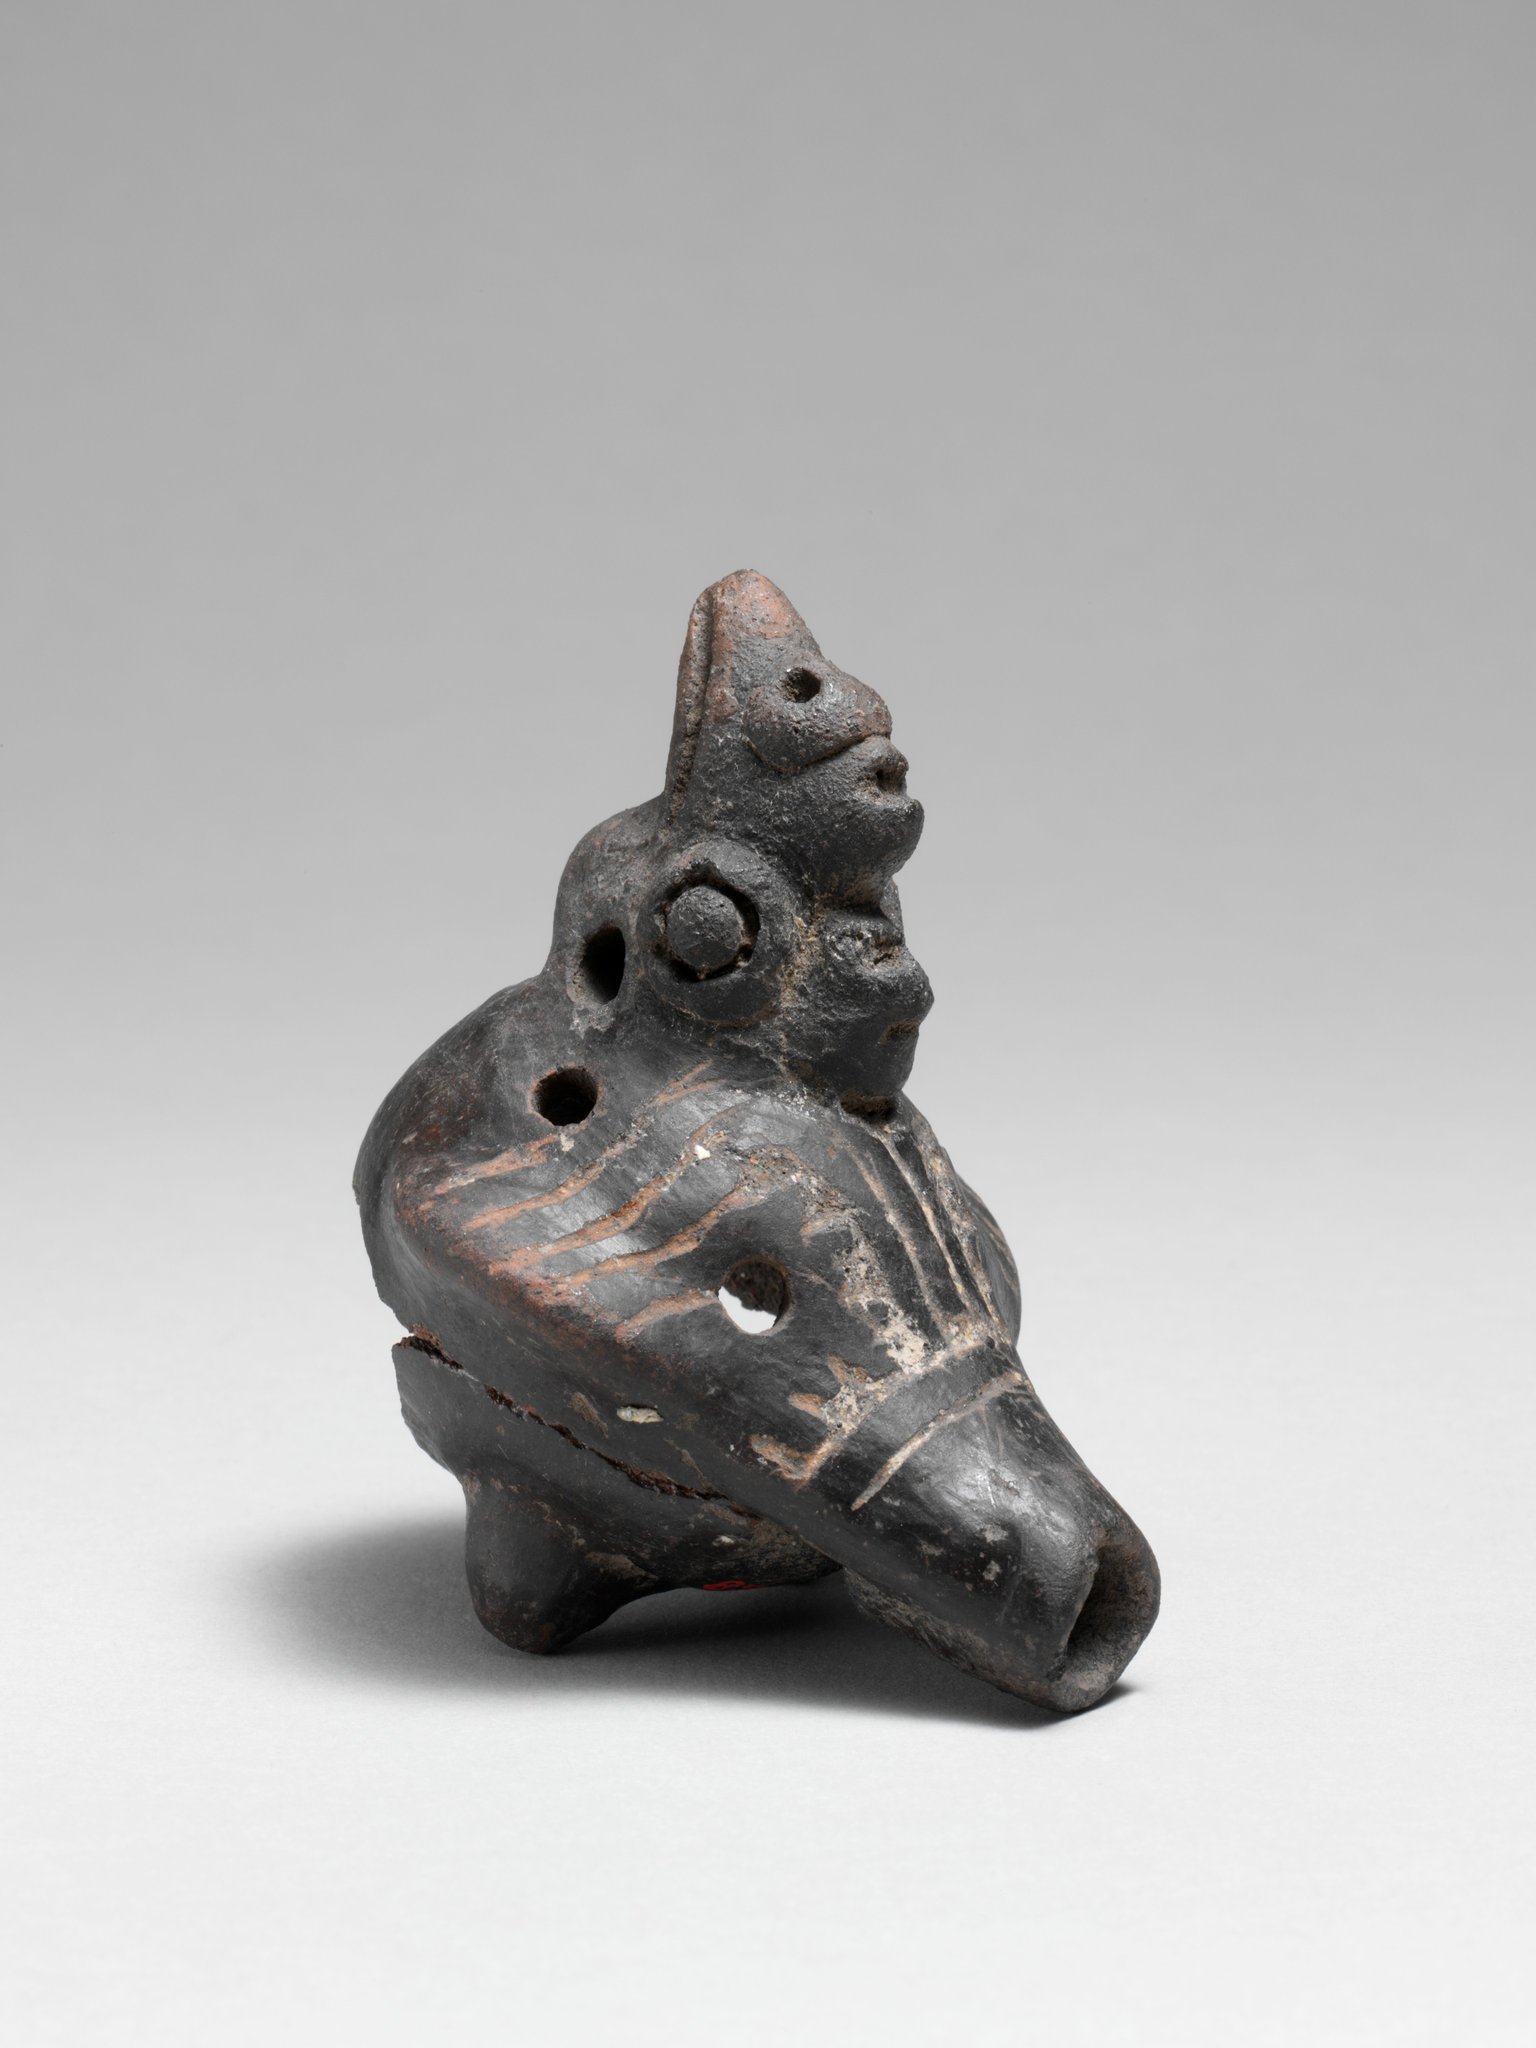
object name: pottery whistle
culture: costa rican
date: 800-1500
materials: pottery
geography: costa rica